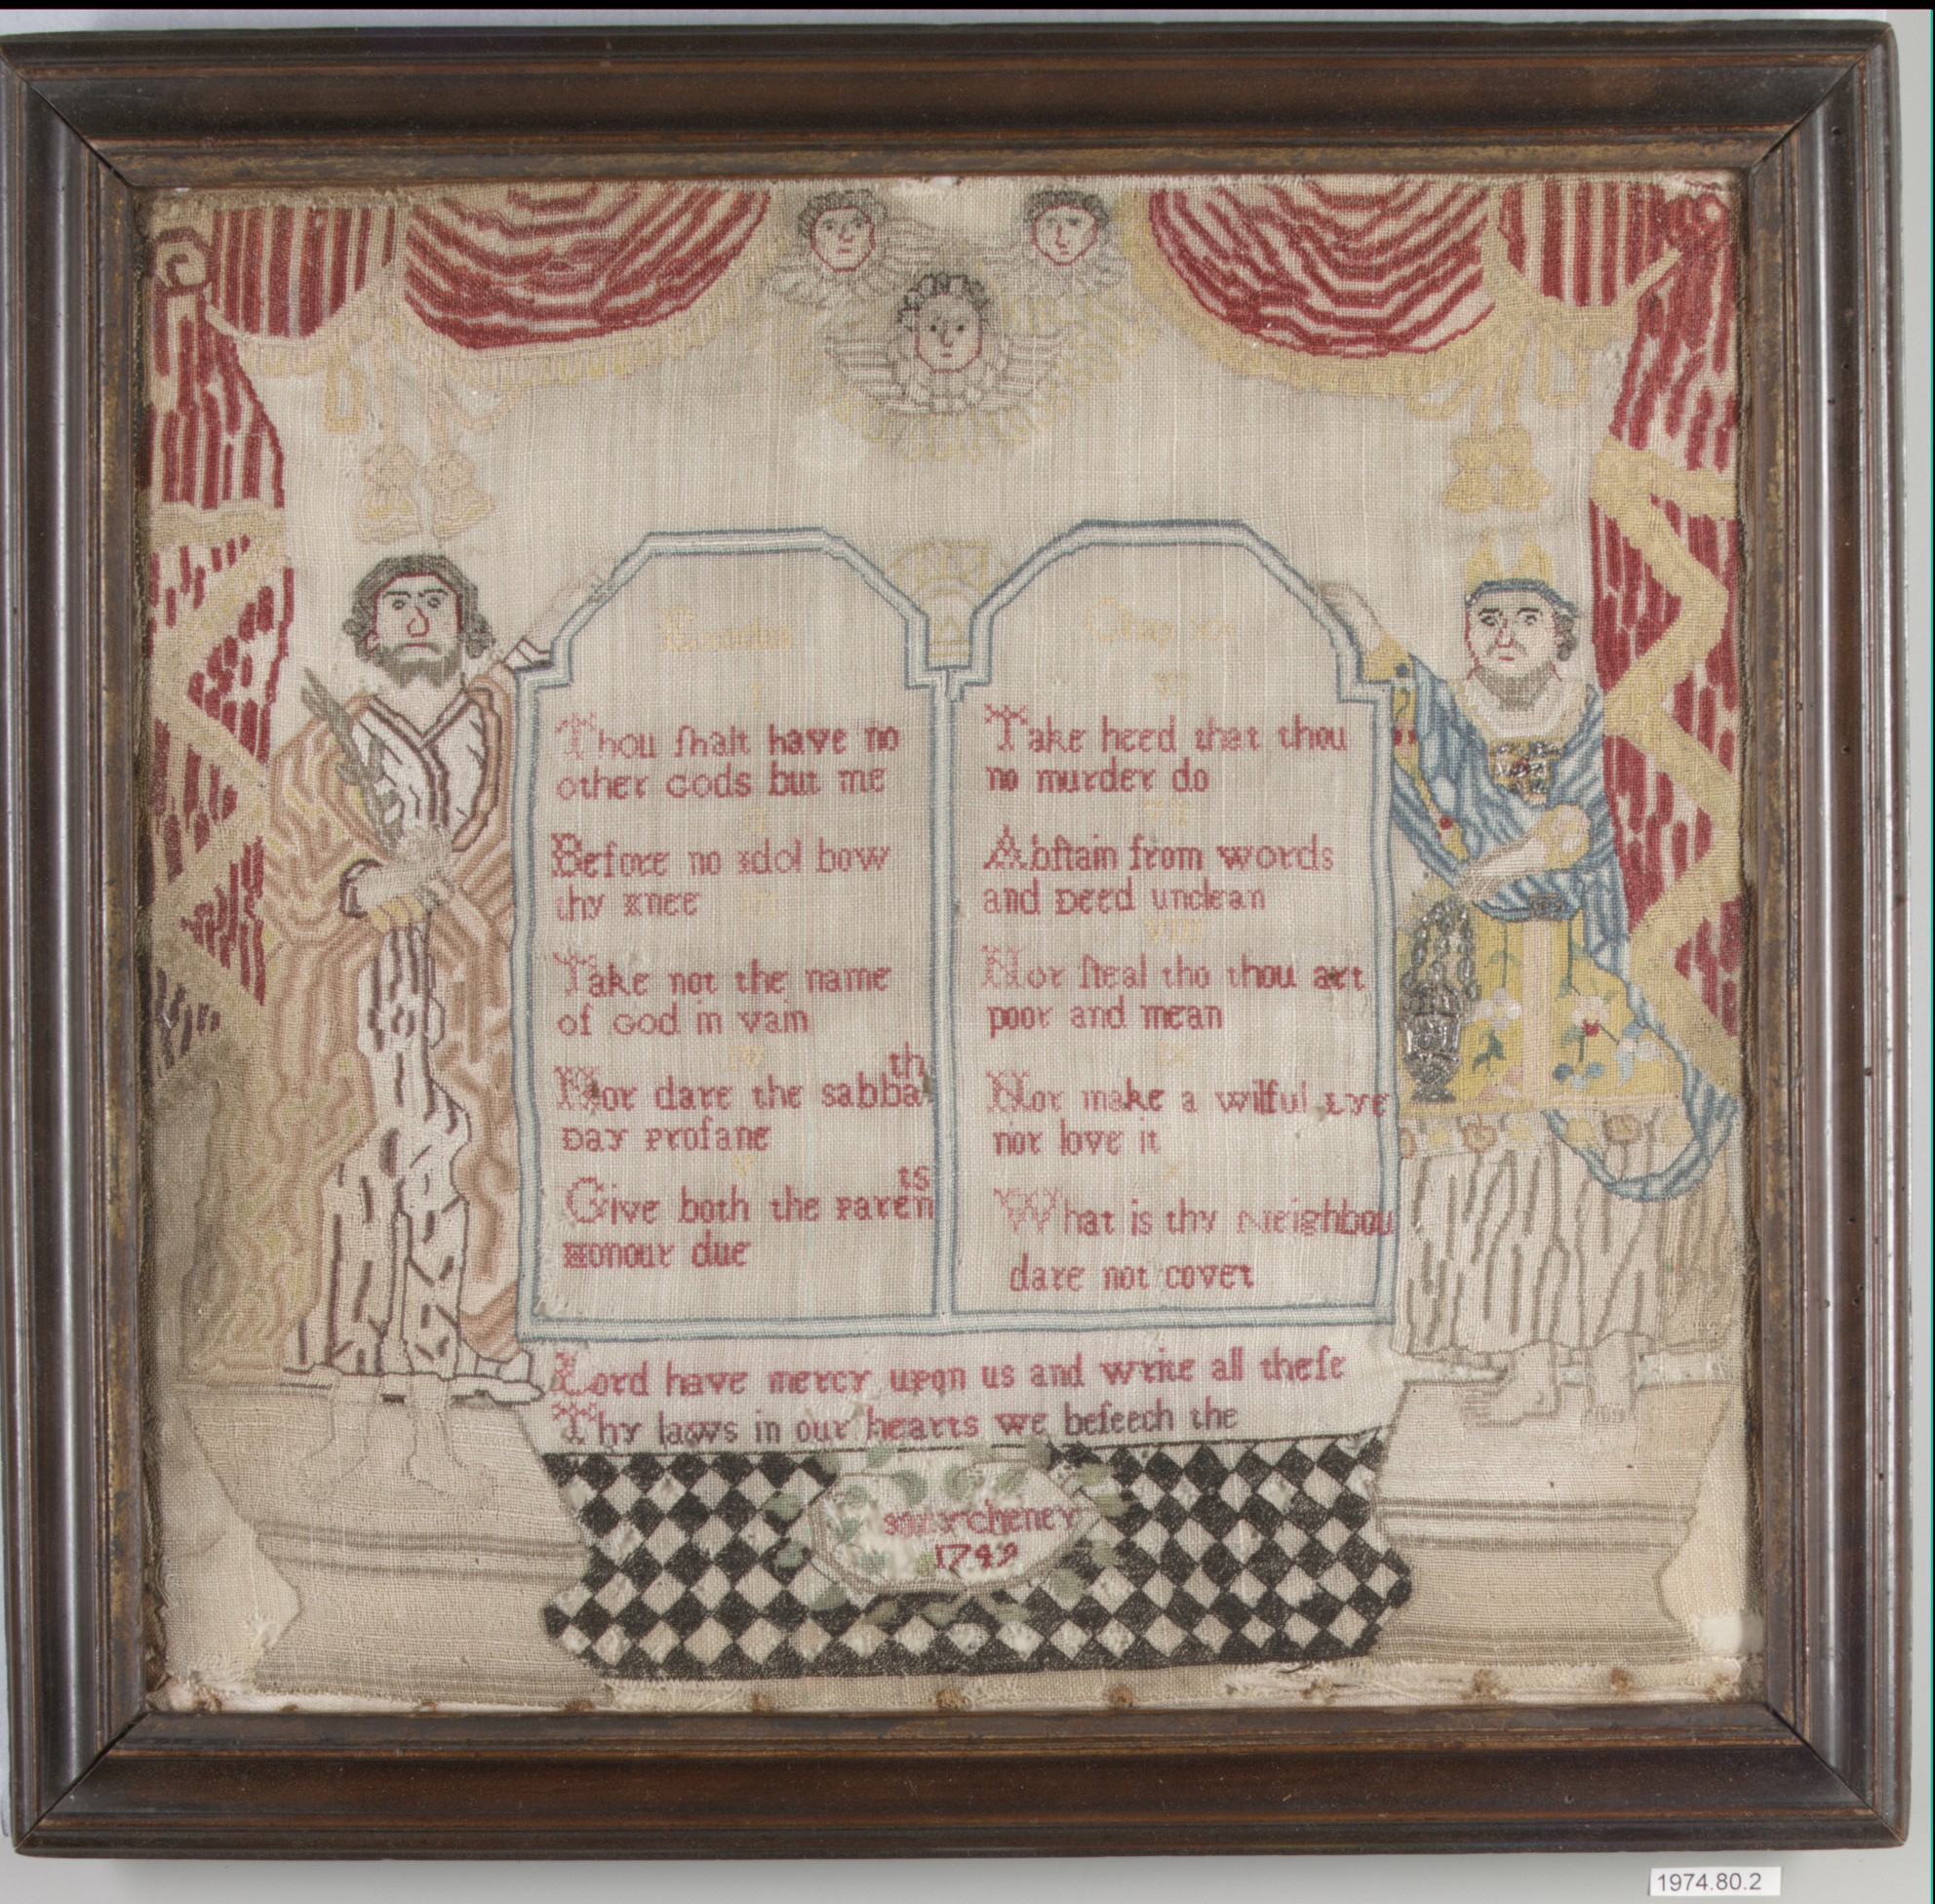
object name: sampler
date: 1749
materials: linen, silk, wool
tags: men